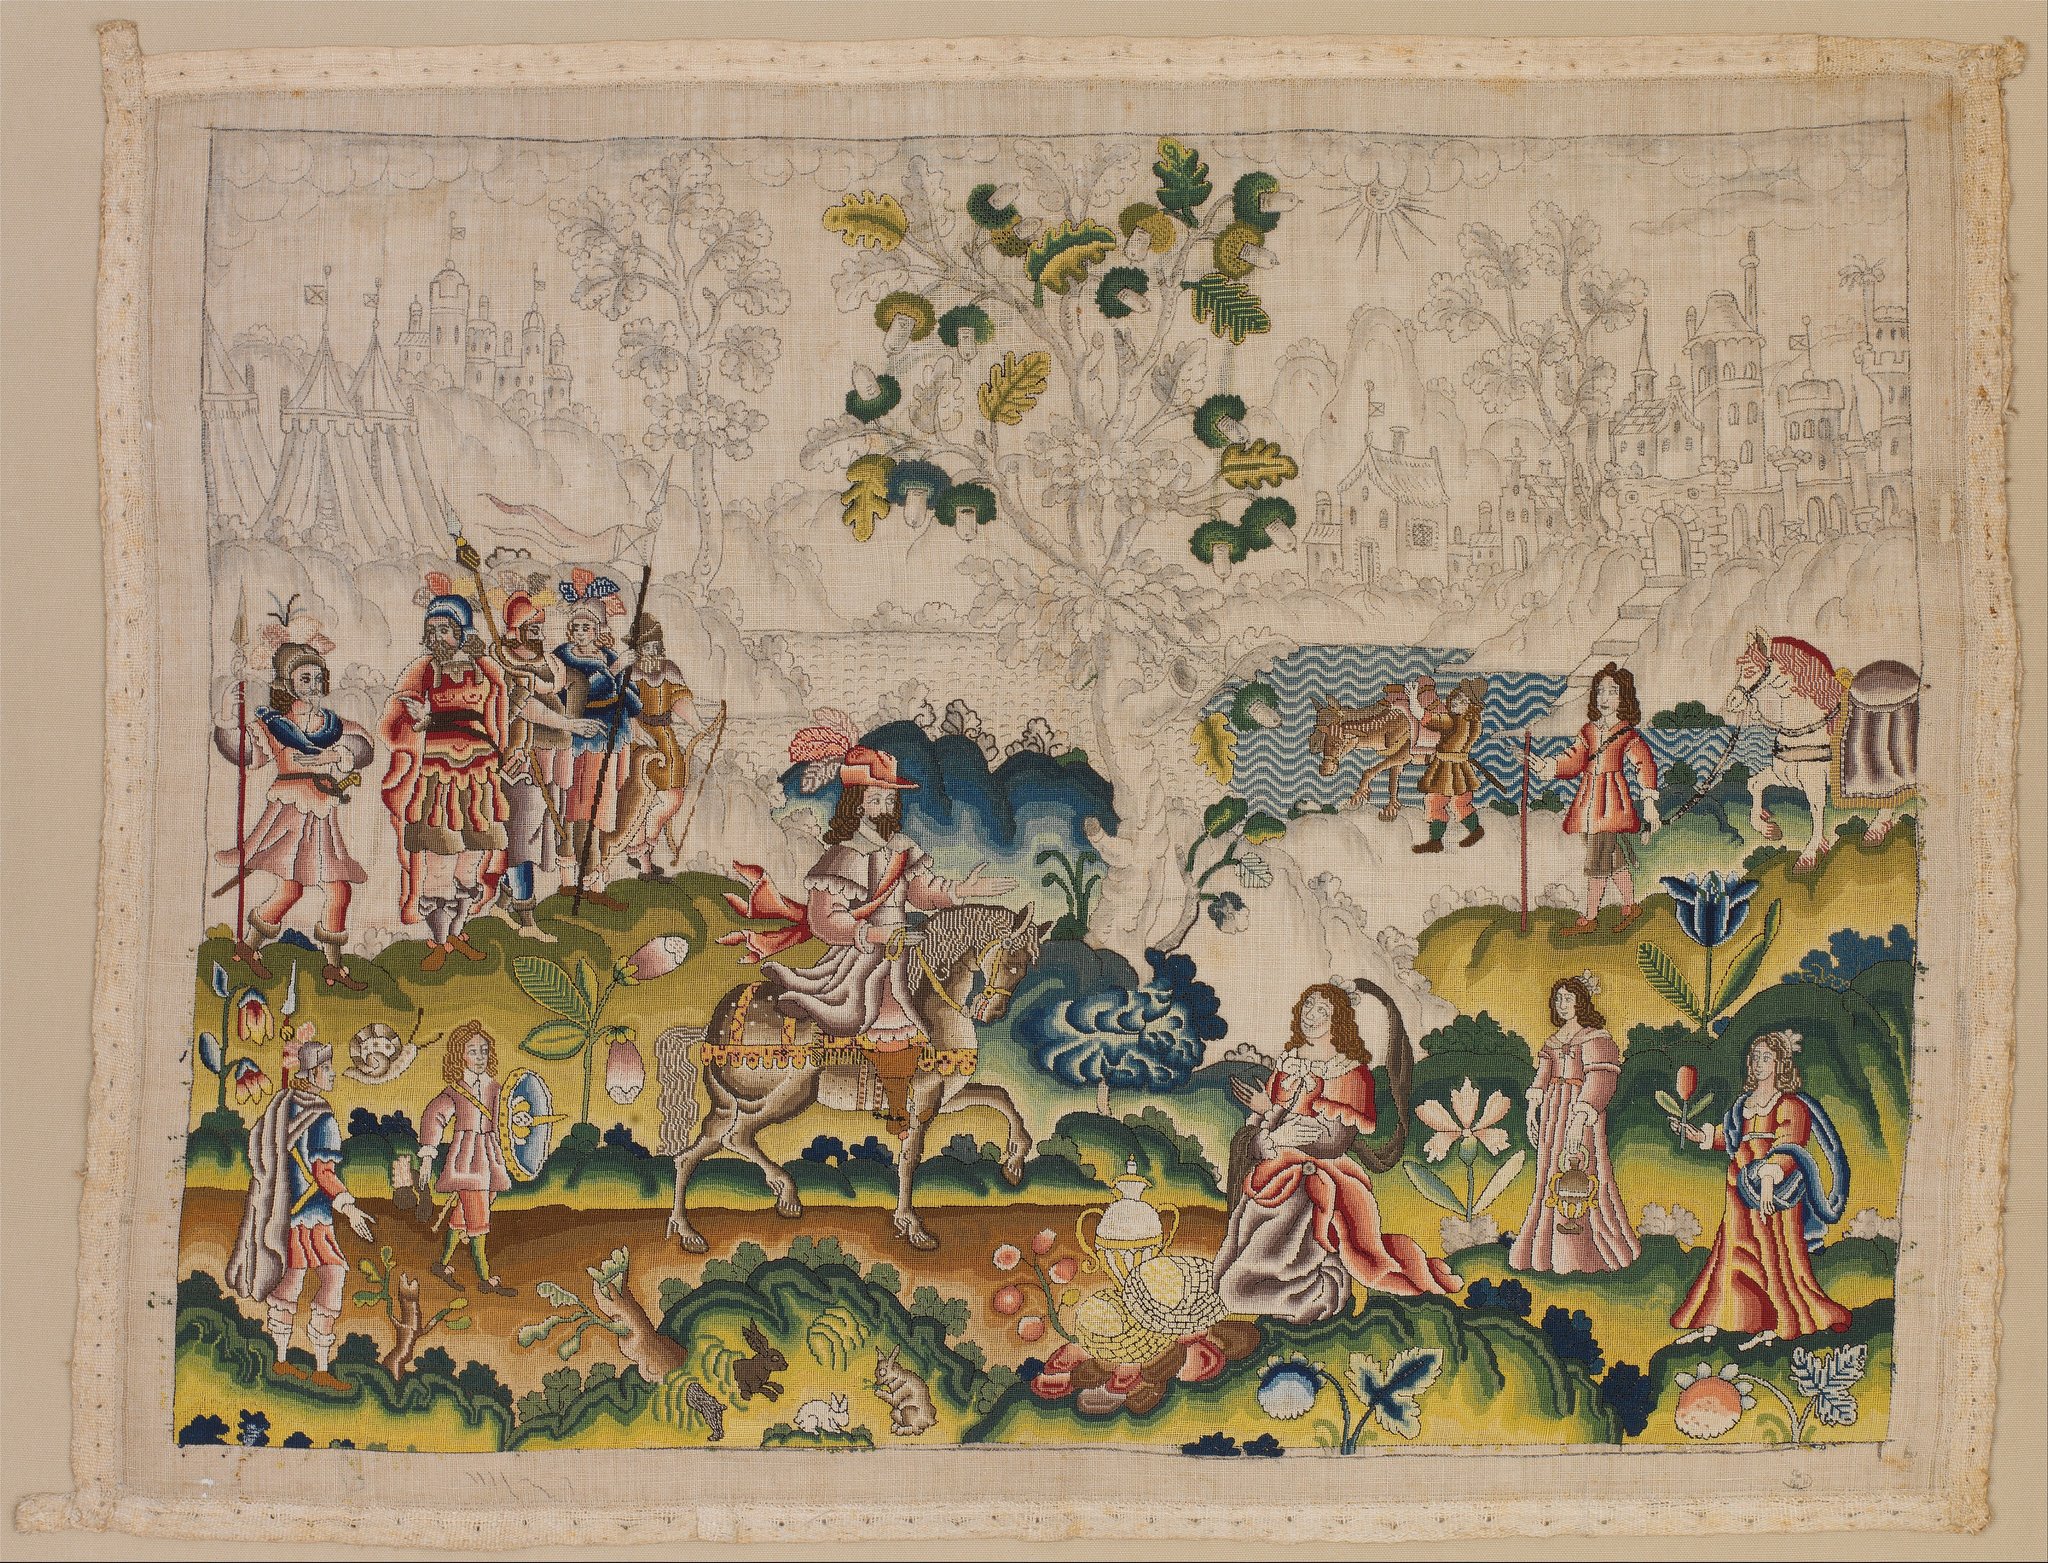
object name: embroidered picture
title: David and Abigail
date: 1634-1666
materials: linen, thread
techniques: embroidery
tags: soldiers,women,horses,snails,rabbits,david